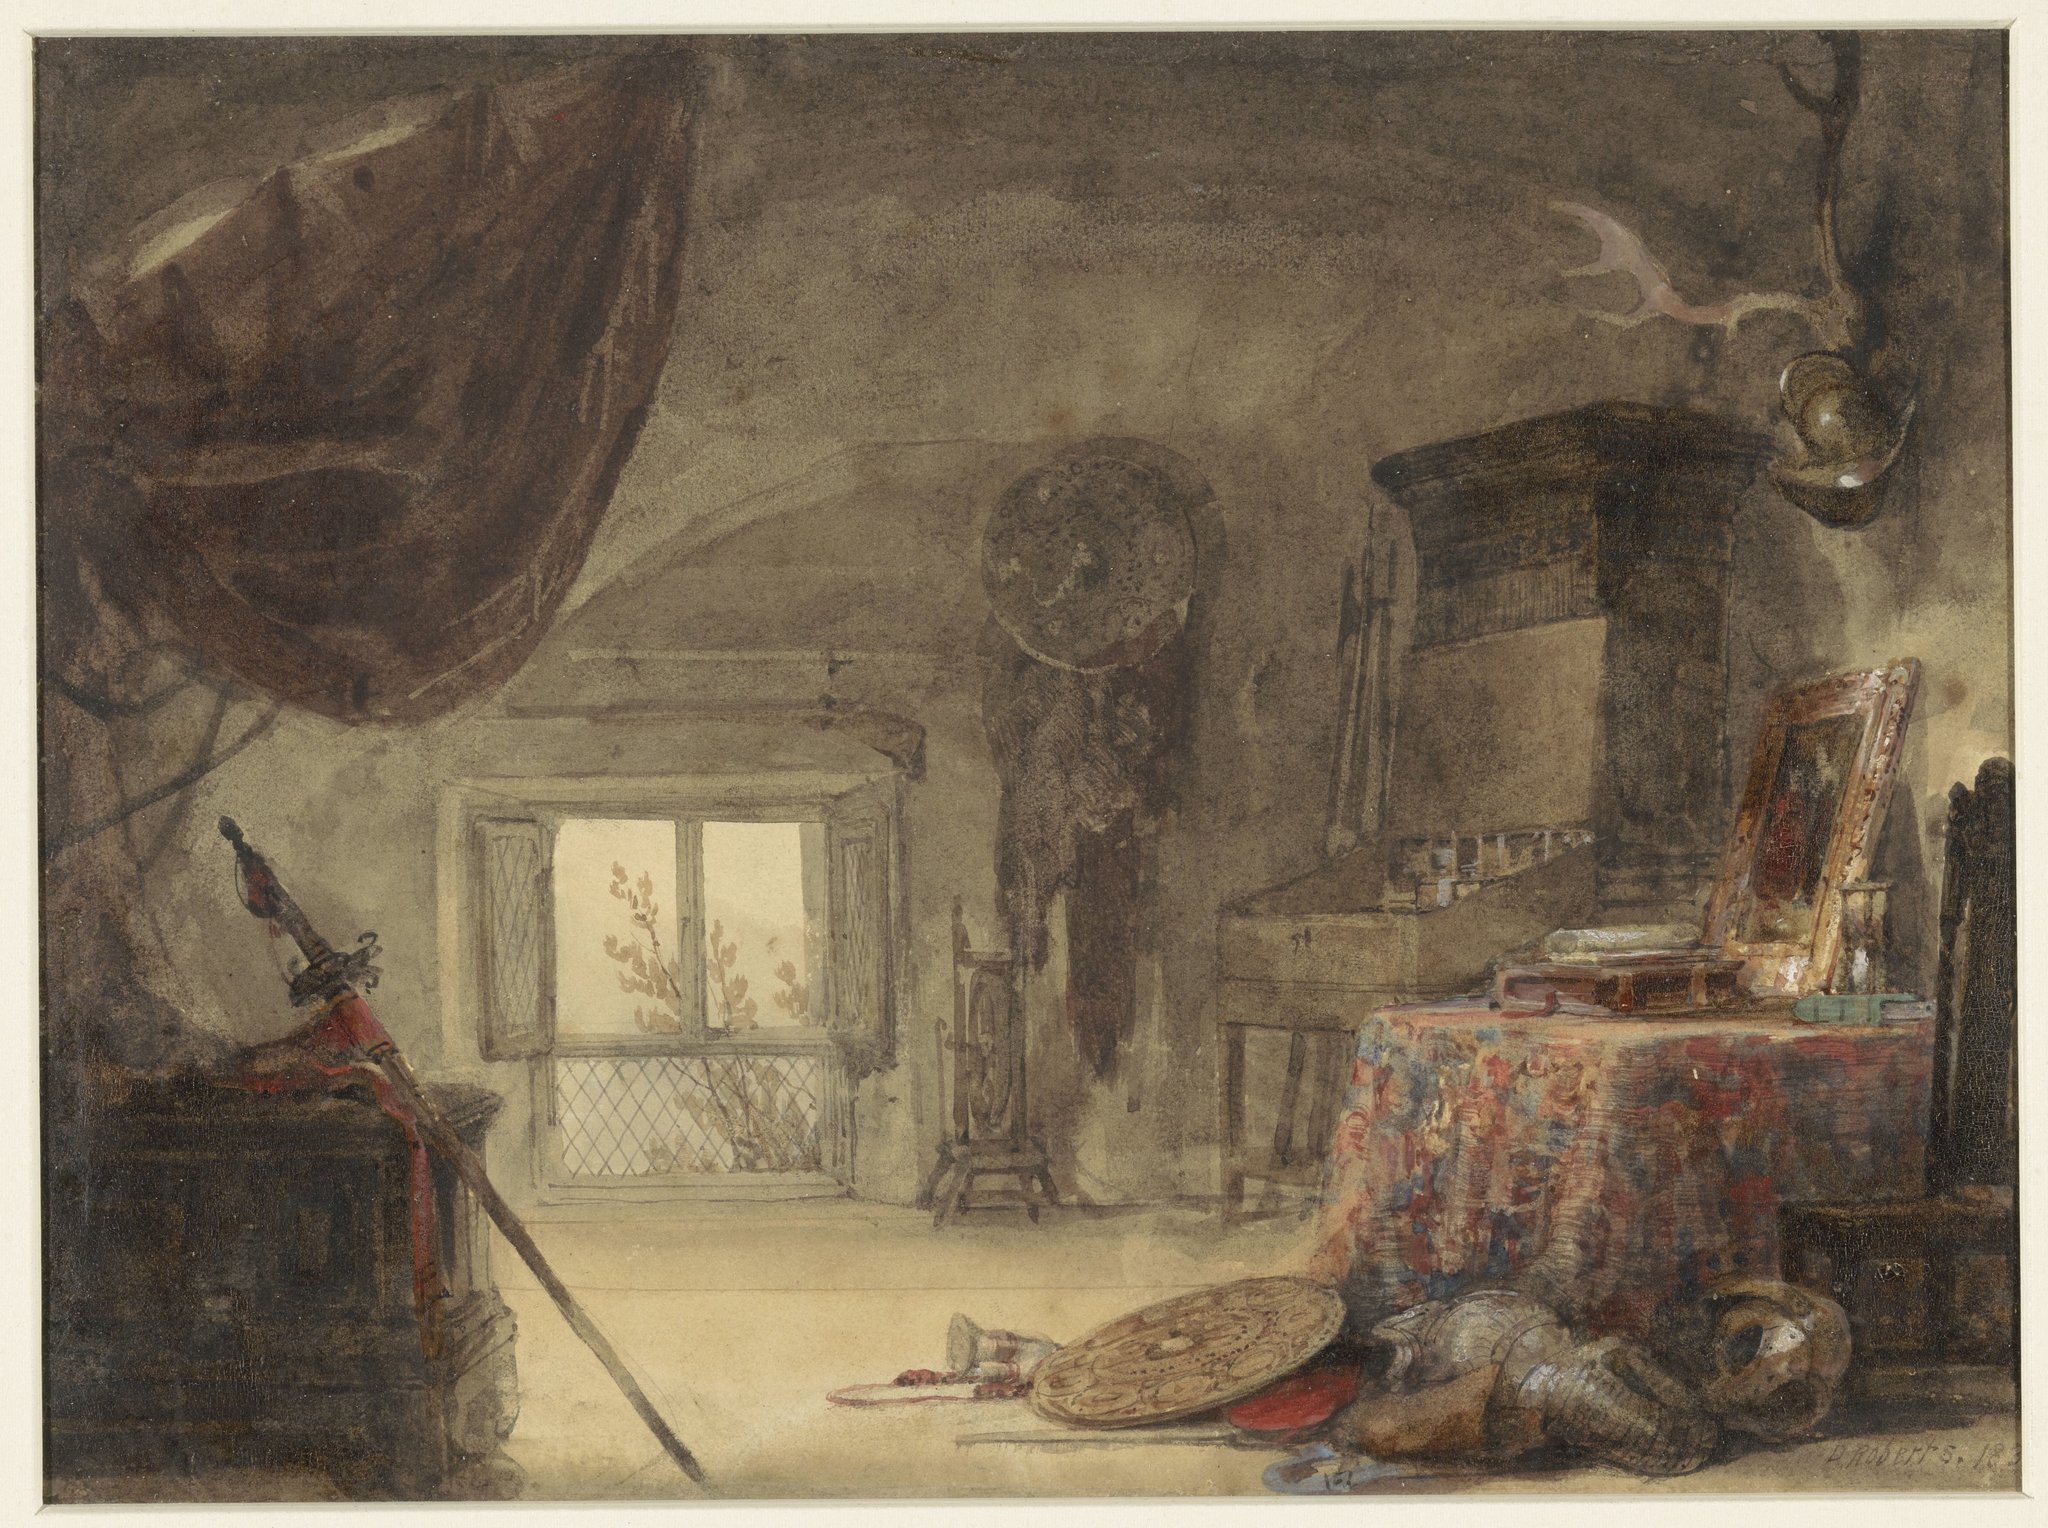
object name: drawing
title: Zoldervertrek, ingericht als atelier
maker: david roberts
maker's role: draughtsman, painter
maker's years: 1796-1864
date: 1830-1839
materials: paper, watercolor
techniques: brush, varnishing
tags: attic, loft, workshop, studio ~ painter, studio requisites ~ painter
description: Schildersatelier met harnas, schild, zwaard, helm.